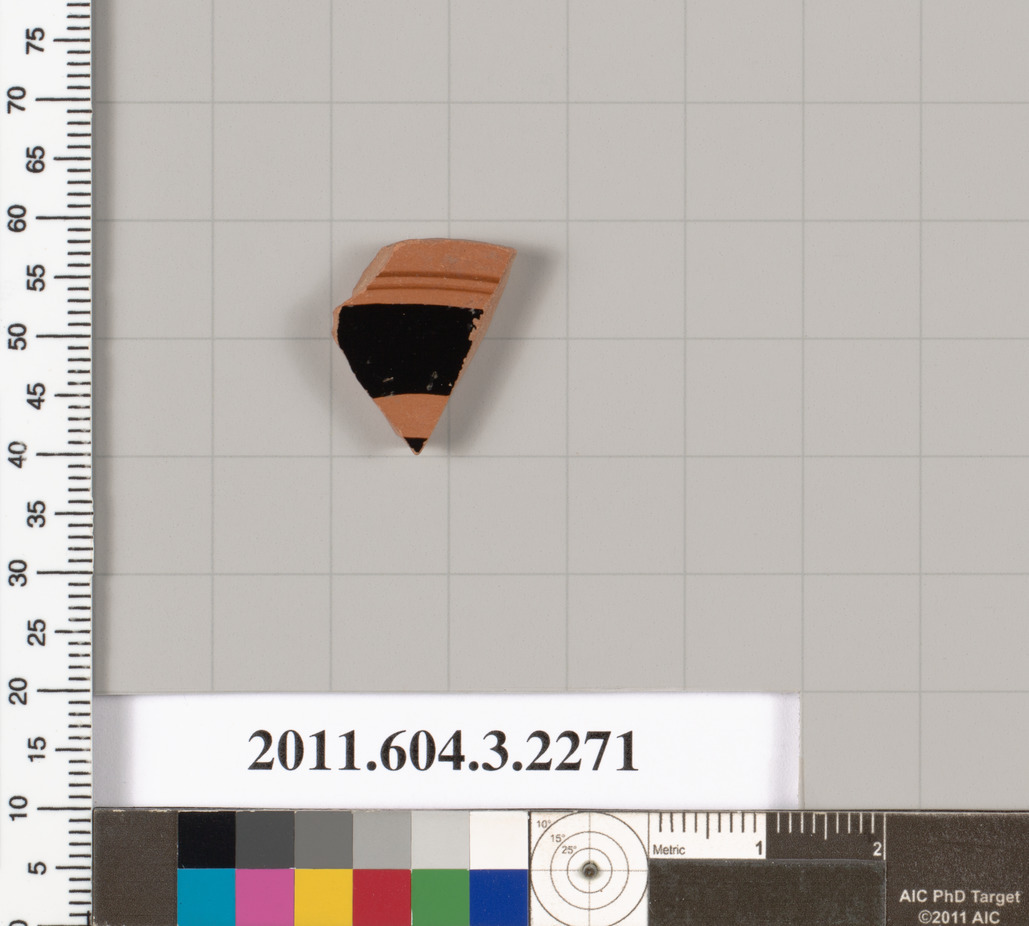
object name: kylix fragment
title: Terracotta fragment of a kylix (drinking cup)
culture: greek, attic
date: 600-401 BCE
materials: terracotta